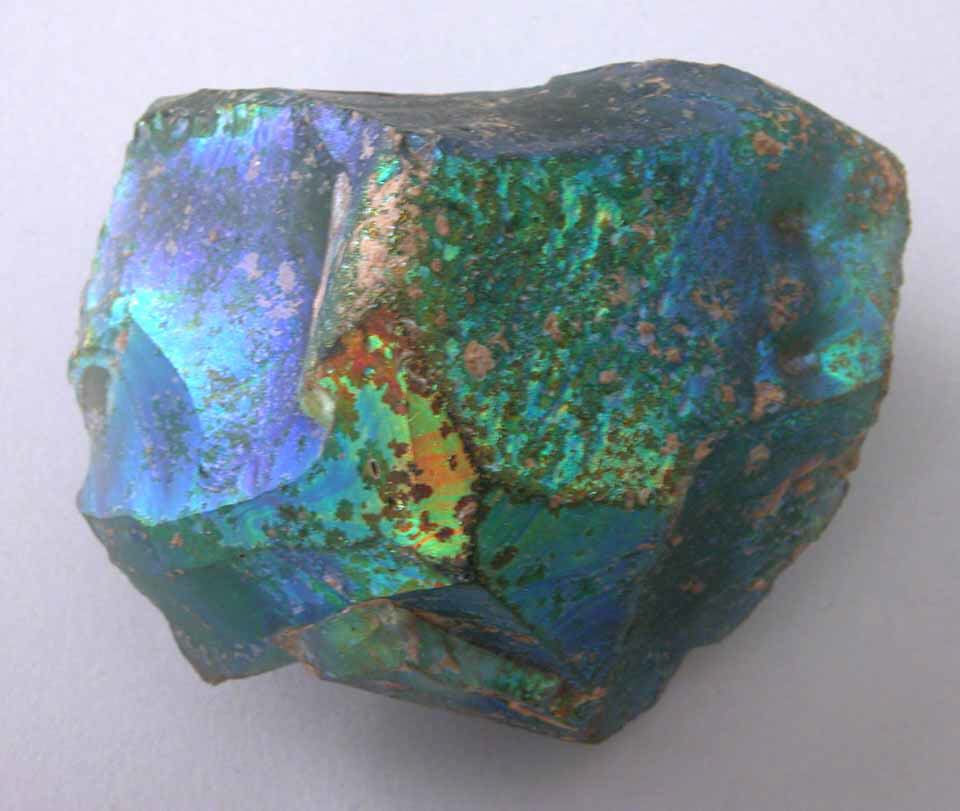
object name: ring weight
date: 701-900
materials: glass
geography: egypt